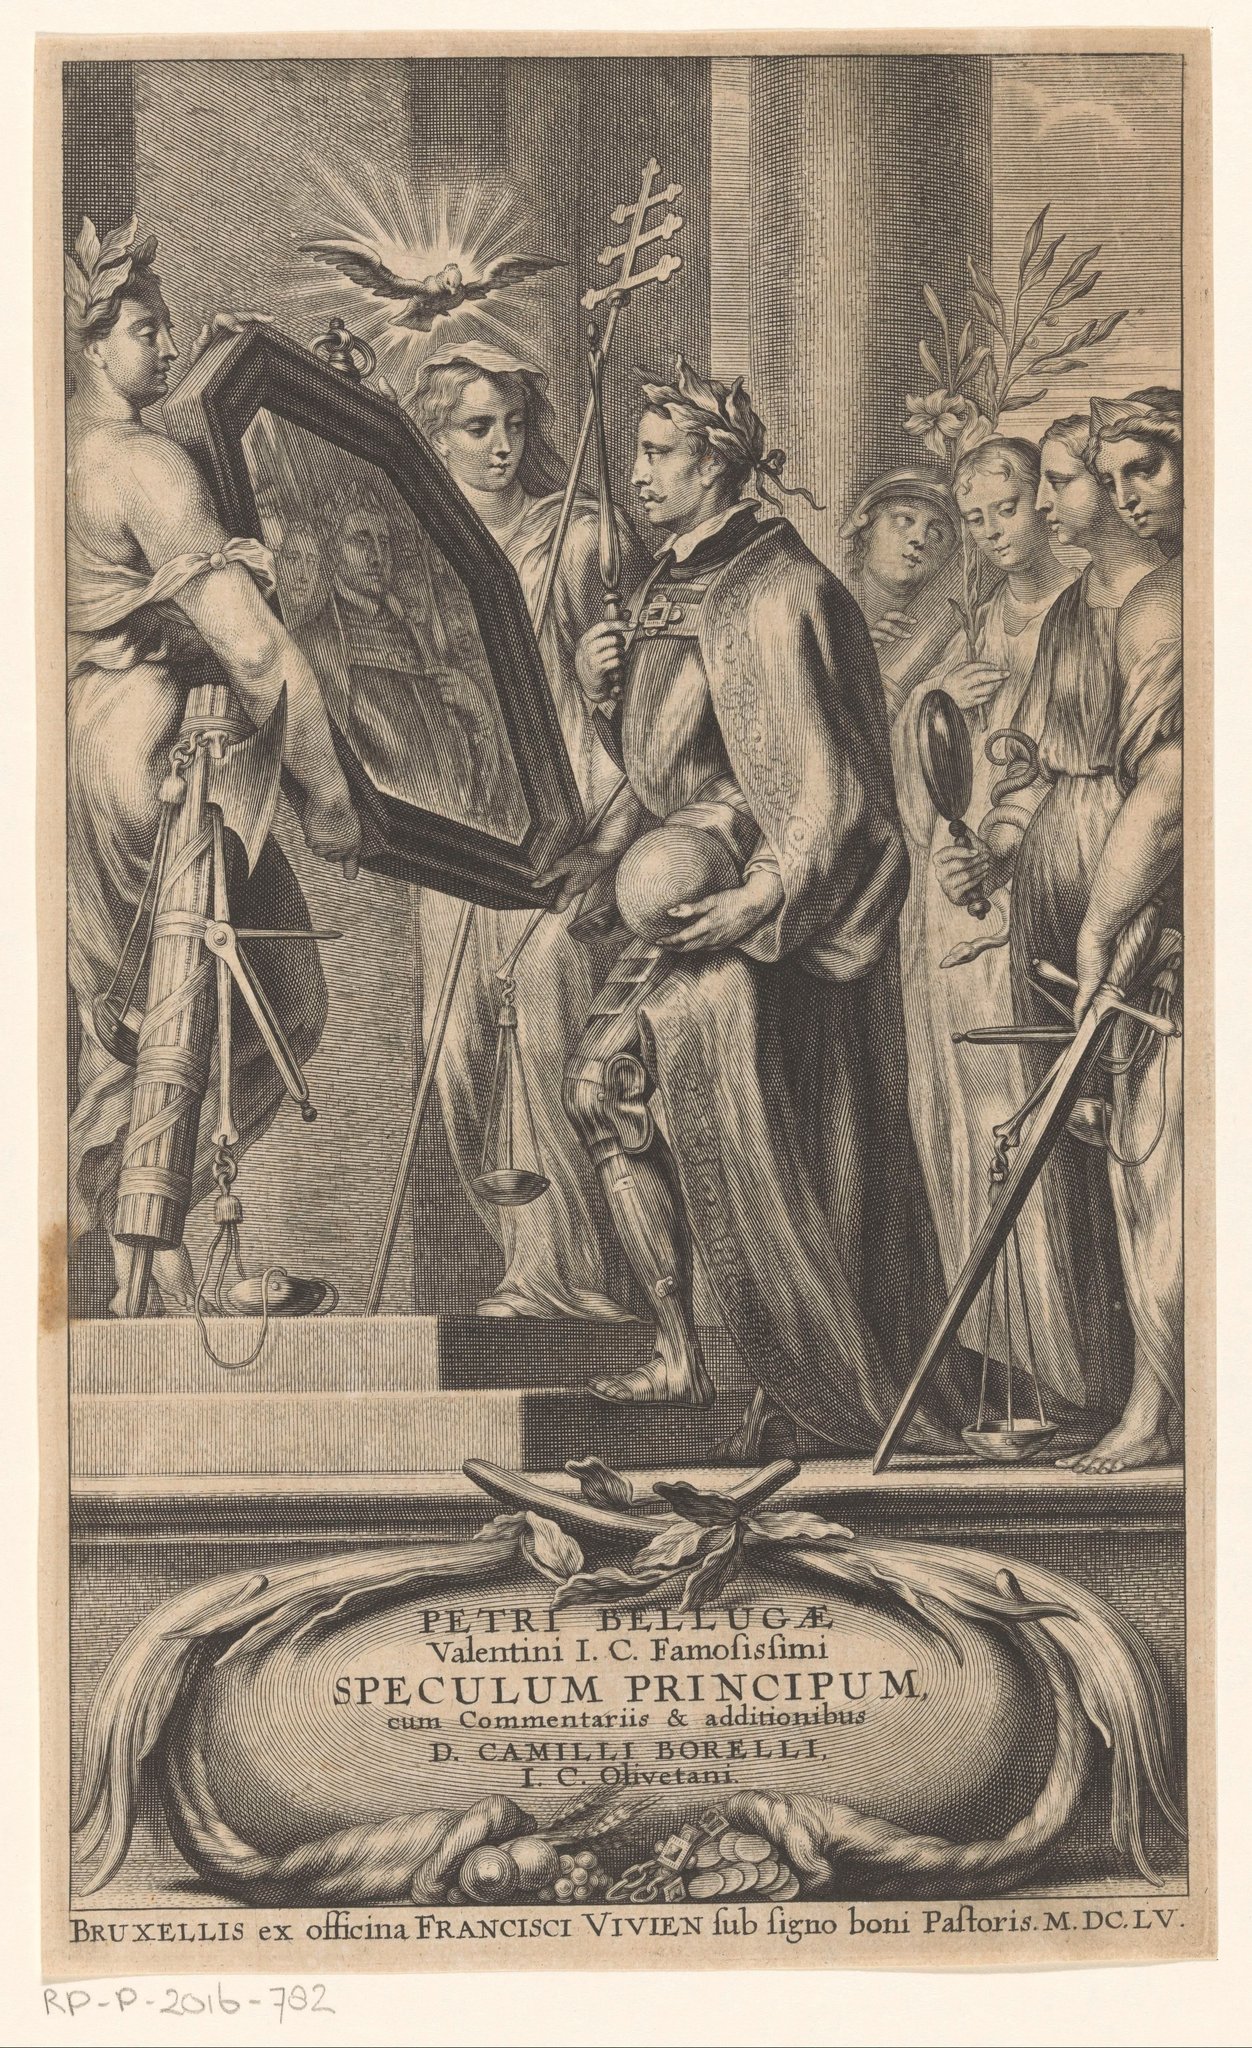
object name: print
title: Koning wordt spiegel voorgehouden door Rechtvaardigheid en Geloof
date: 1655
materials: paper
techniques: engraving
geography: brussels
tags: faith, 'fides'; 'fede', 'fede catholica', 'fede christiana', 'fede christiana catholica' (ripa) ~ one of the three theological virtues, mirror, the four cardinal virtues, king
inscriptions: collector's mark: Lugt 240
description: Een koning met lauwerkrans, scepter en globe wordt een spiegel voorgehouden door de personificaties van Rechtvaardigheid met fasces en Geloof met duif en kruisstaf. Achter hem staan de vier kardinale deugden Rechtvaardigheid, Voorzichtigheid, Moed en Gematigdheid. Daaronder een cartouche met hoornen des overvloeds en de titel van het boek.